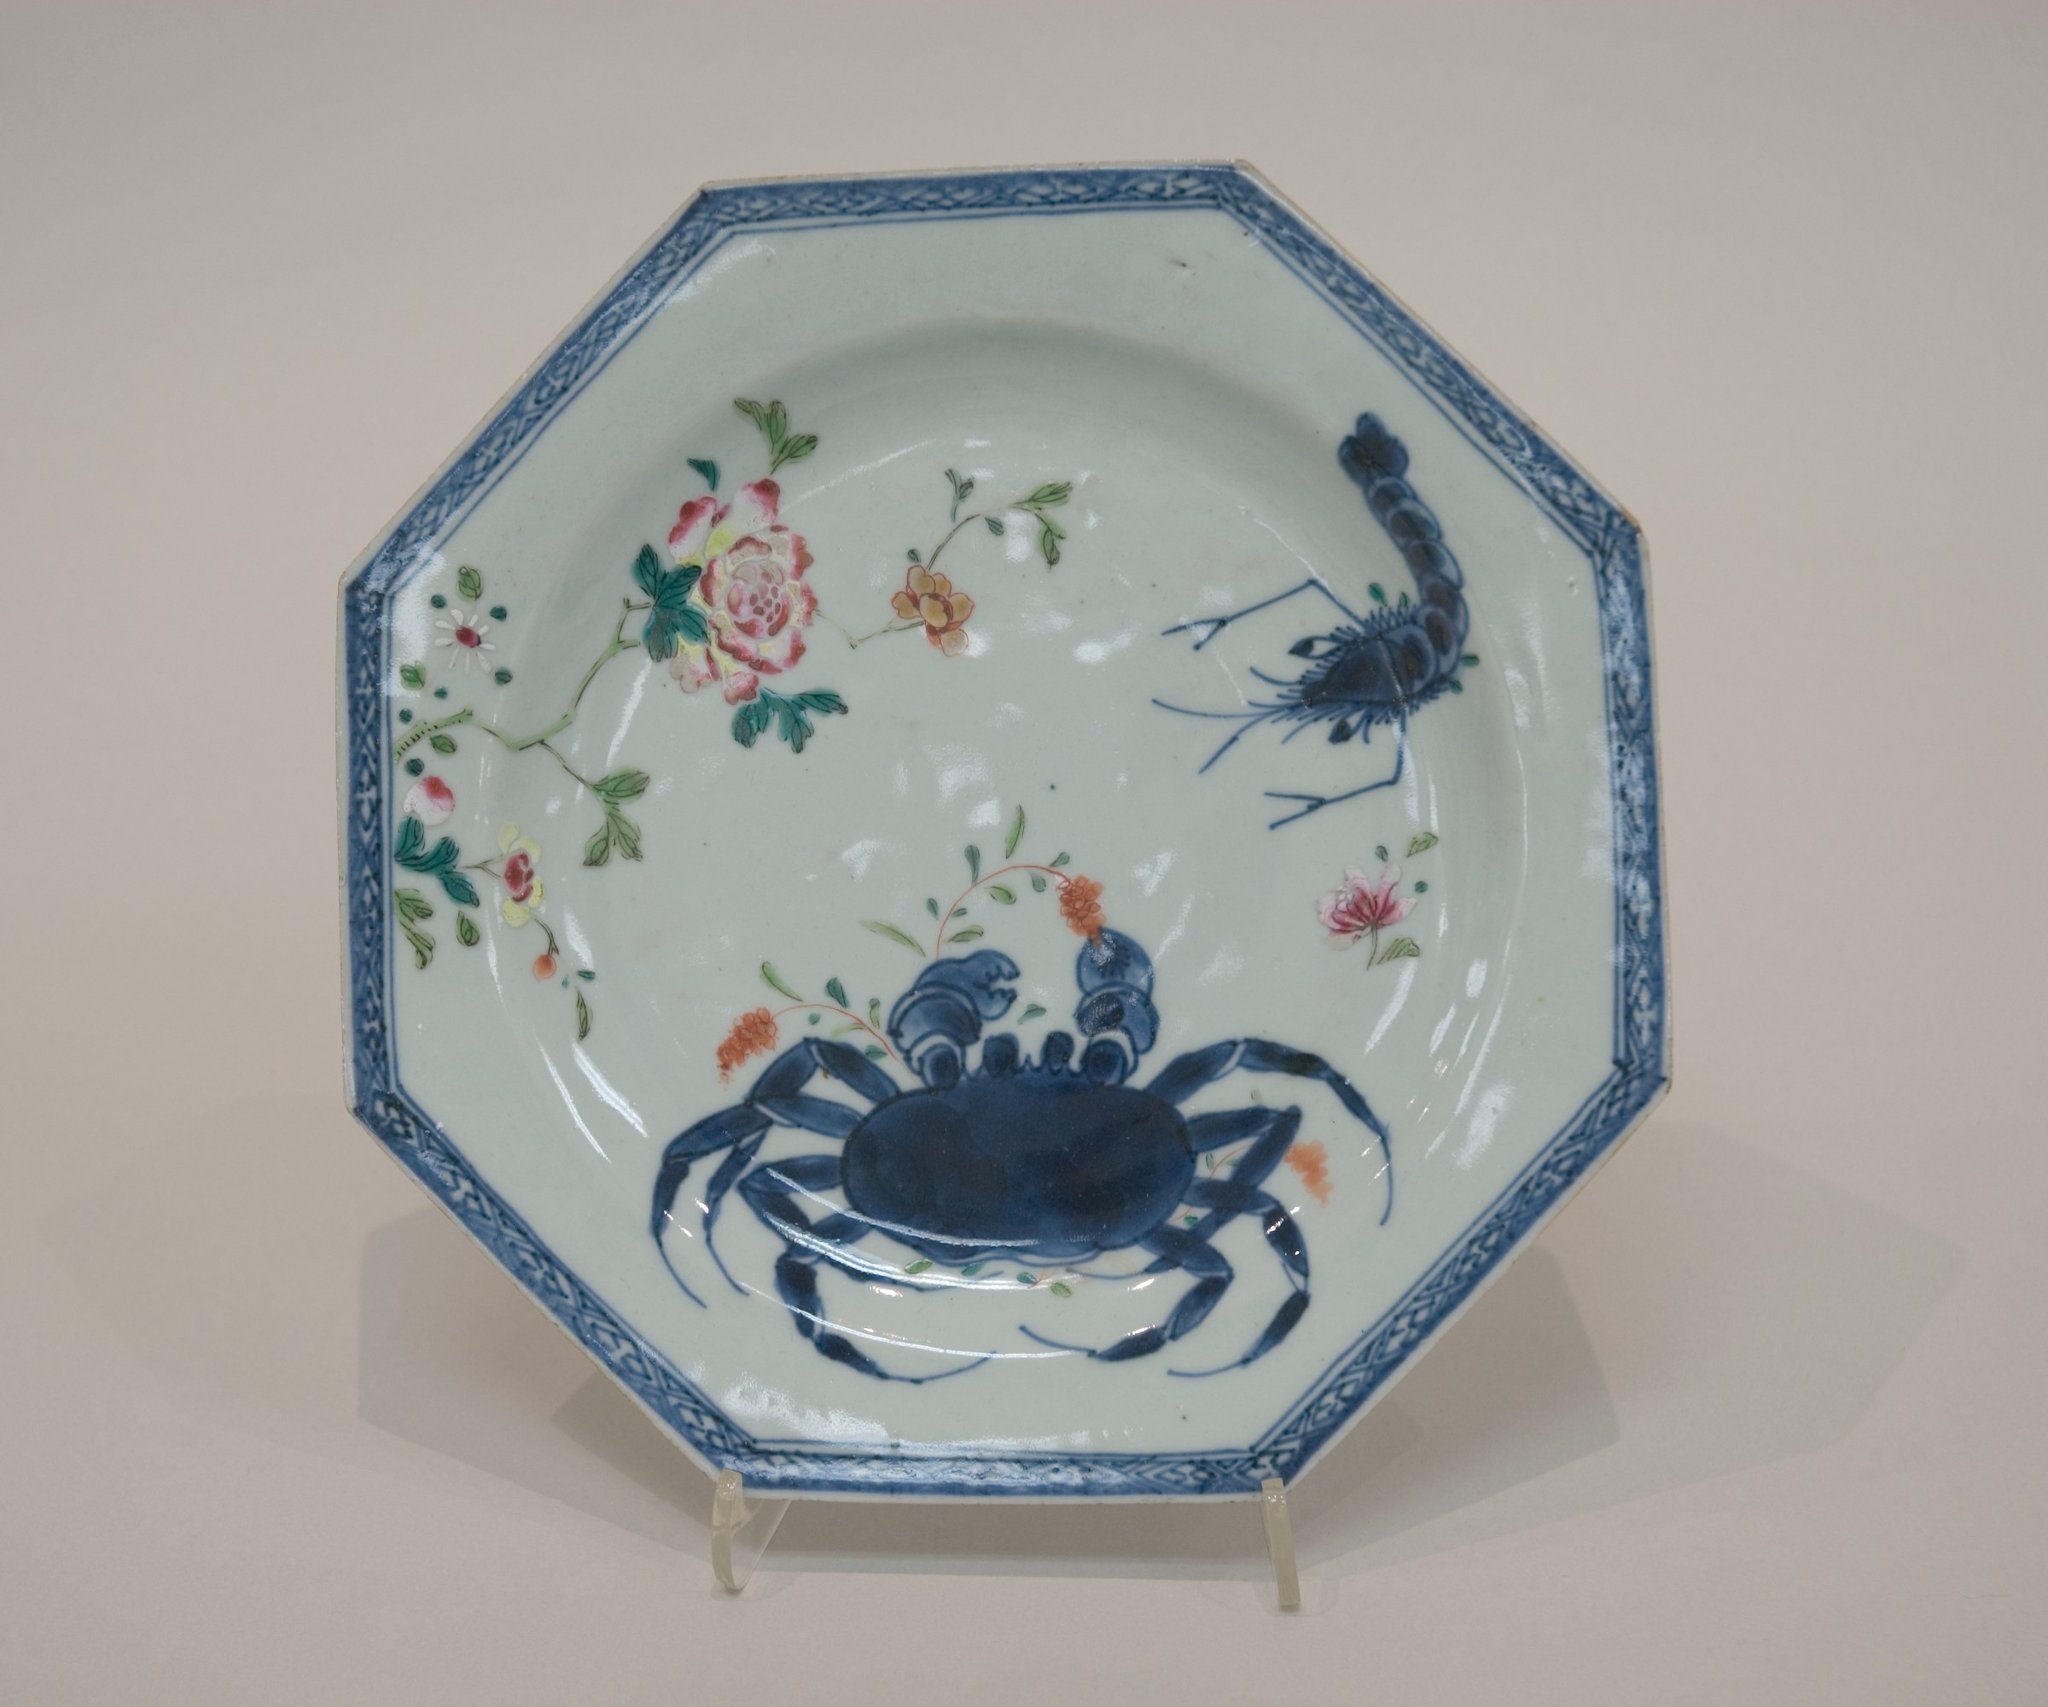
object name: dish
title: Octagonal dish with crab, shrimp, and flowers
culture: chinese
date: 1767-1800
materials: cobalt, enamel, porcelain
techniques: overglaze, painting, polychrome, underglaze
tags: crabs